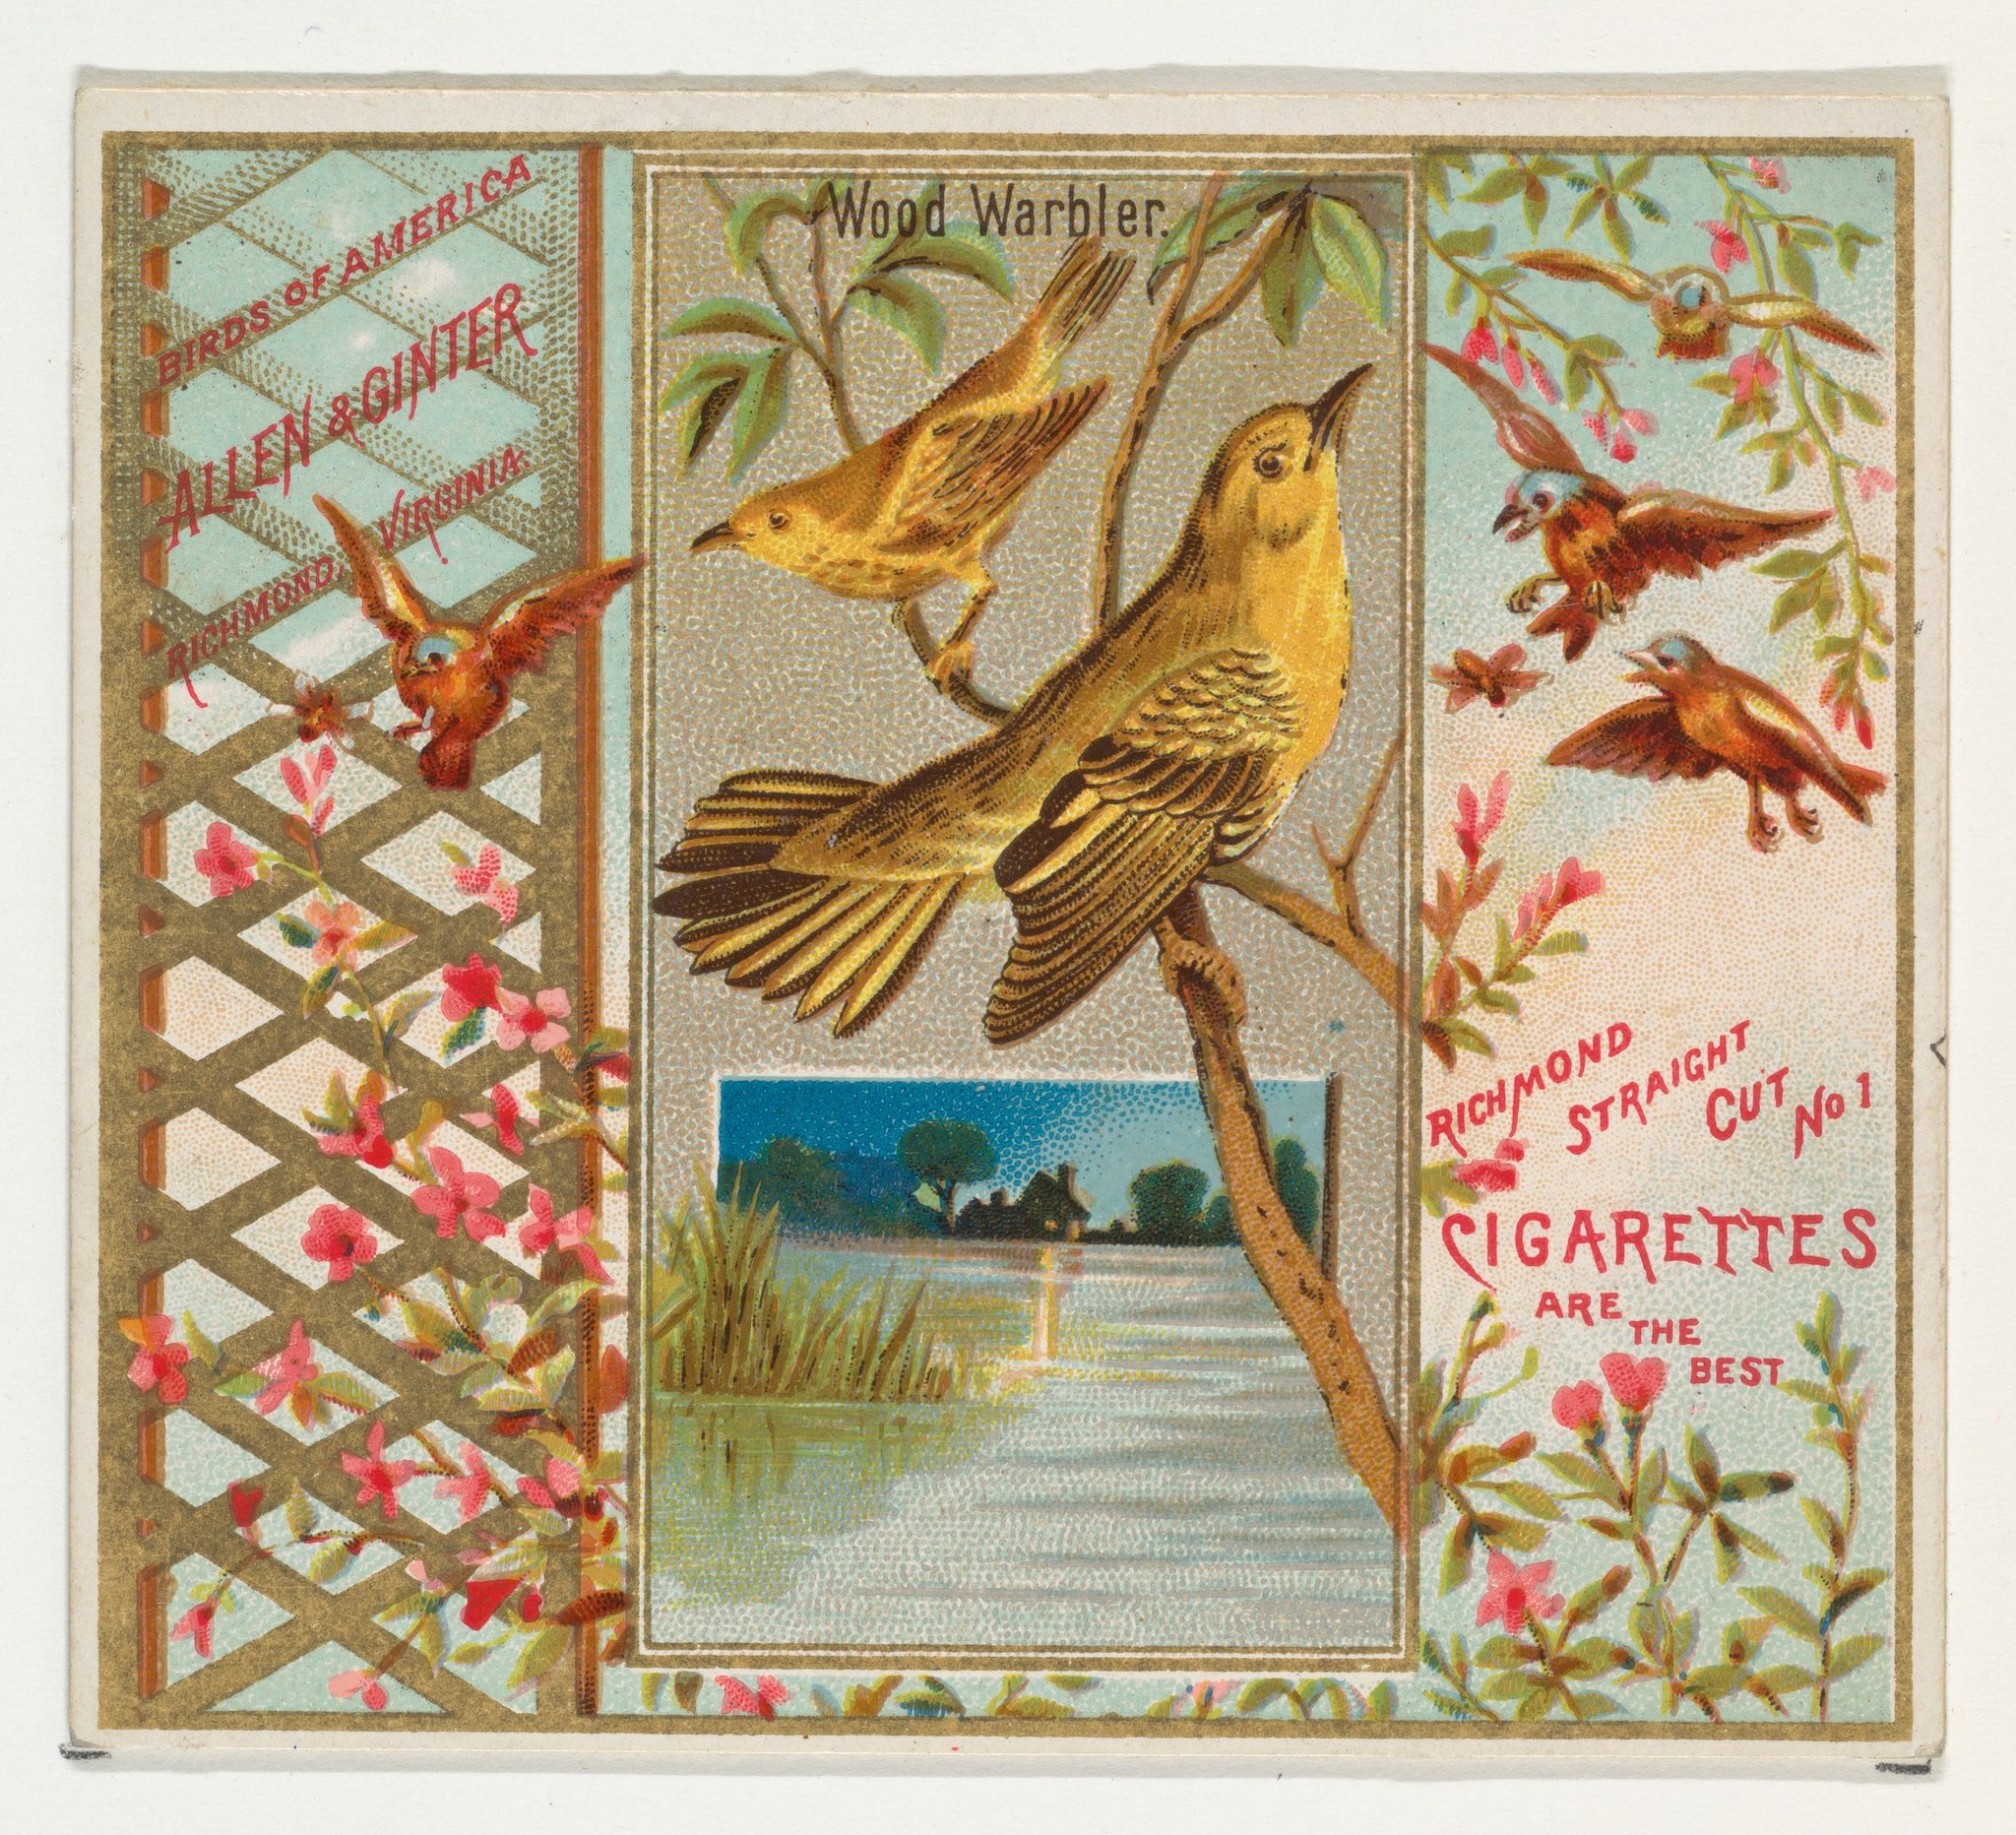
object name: print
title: Wood Warbler, from the Birds of America series (N37) for Allen & Ginter Cigarettes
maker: allen & ginter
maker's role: publisher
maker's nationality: american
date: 1888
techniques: color lithograph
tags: birds